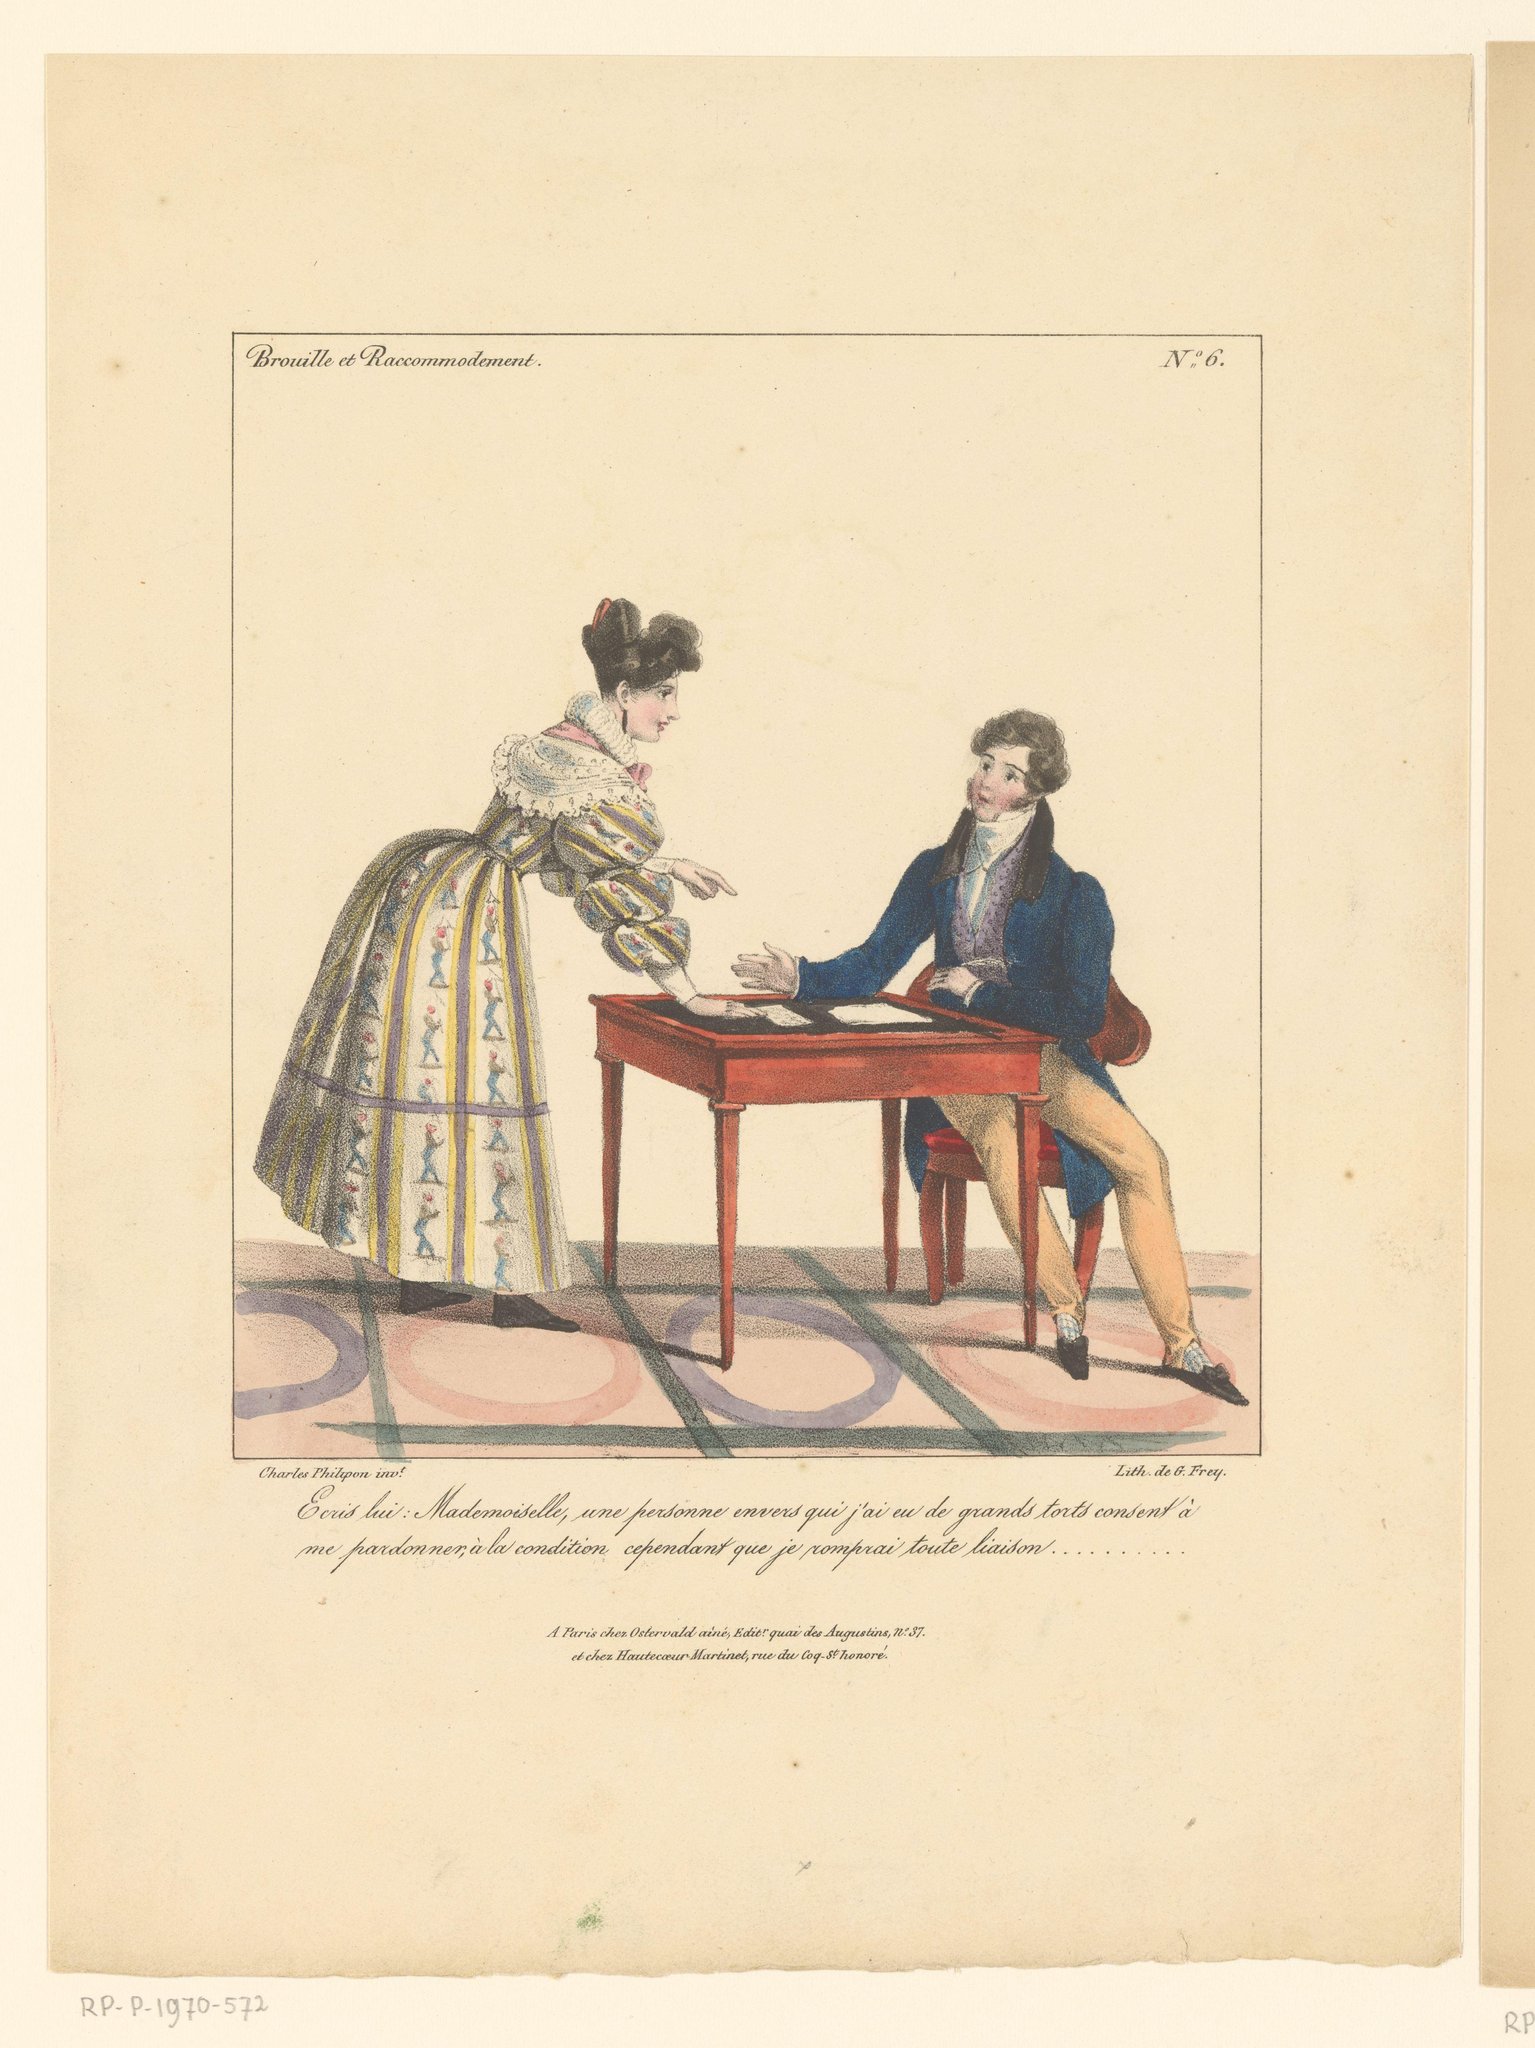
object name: print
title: Relatieperikelen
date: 1828-1830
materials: paper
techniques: hand coloring, lithograph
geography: paris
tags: adultery, letter, envelope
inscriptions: collector's mark: Lugt 2228